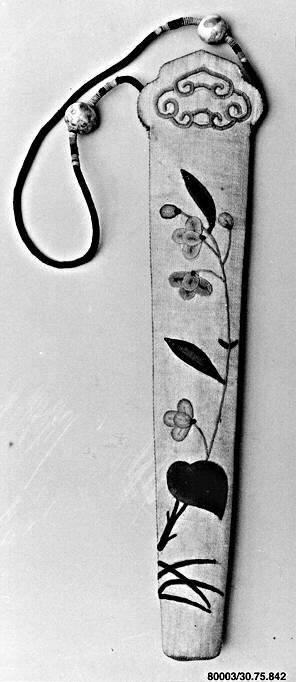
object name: fan holder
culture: chinese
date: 1701-1900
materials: silk